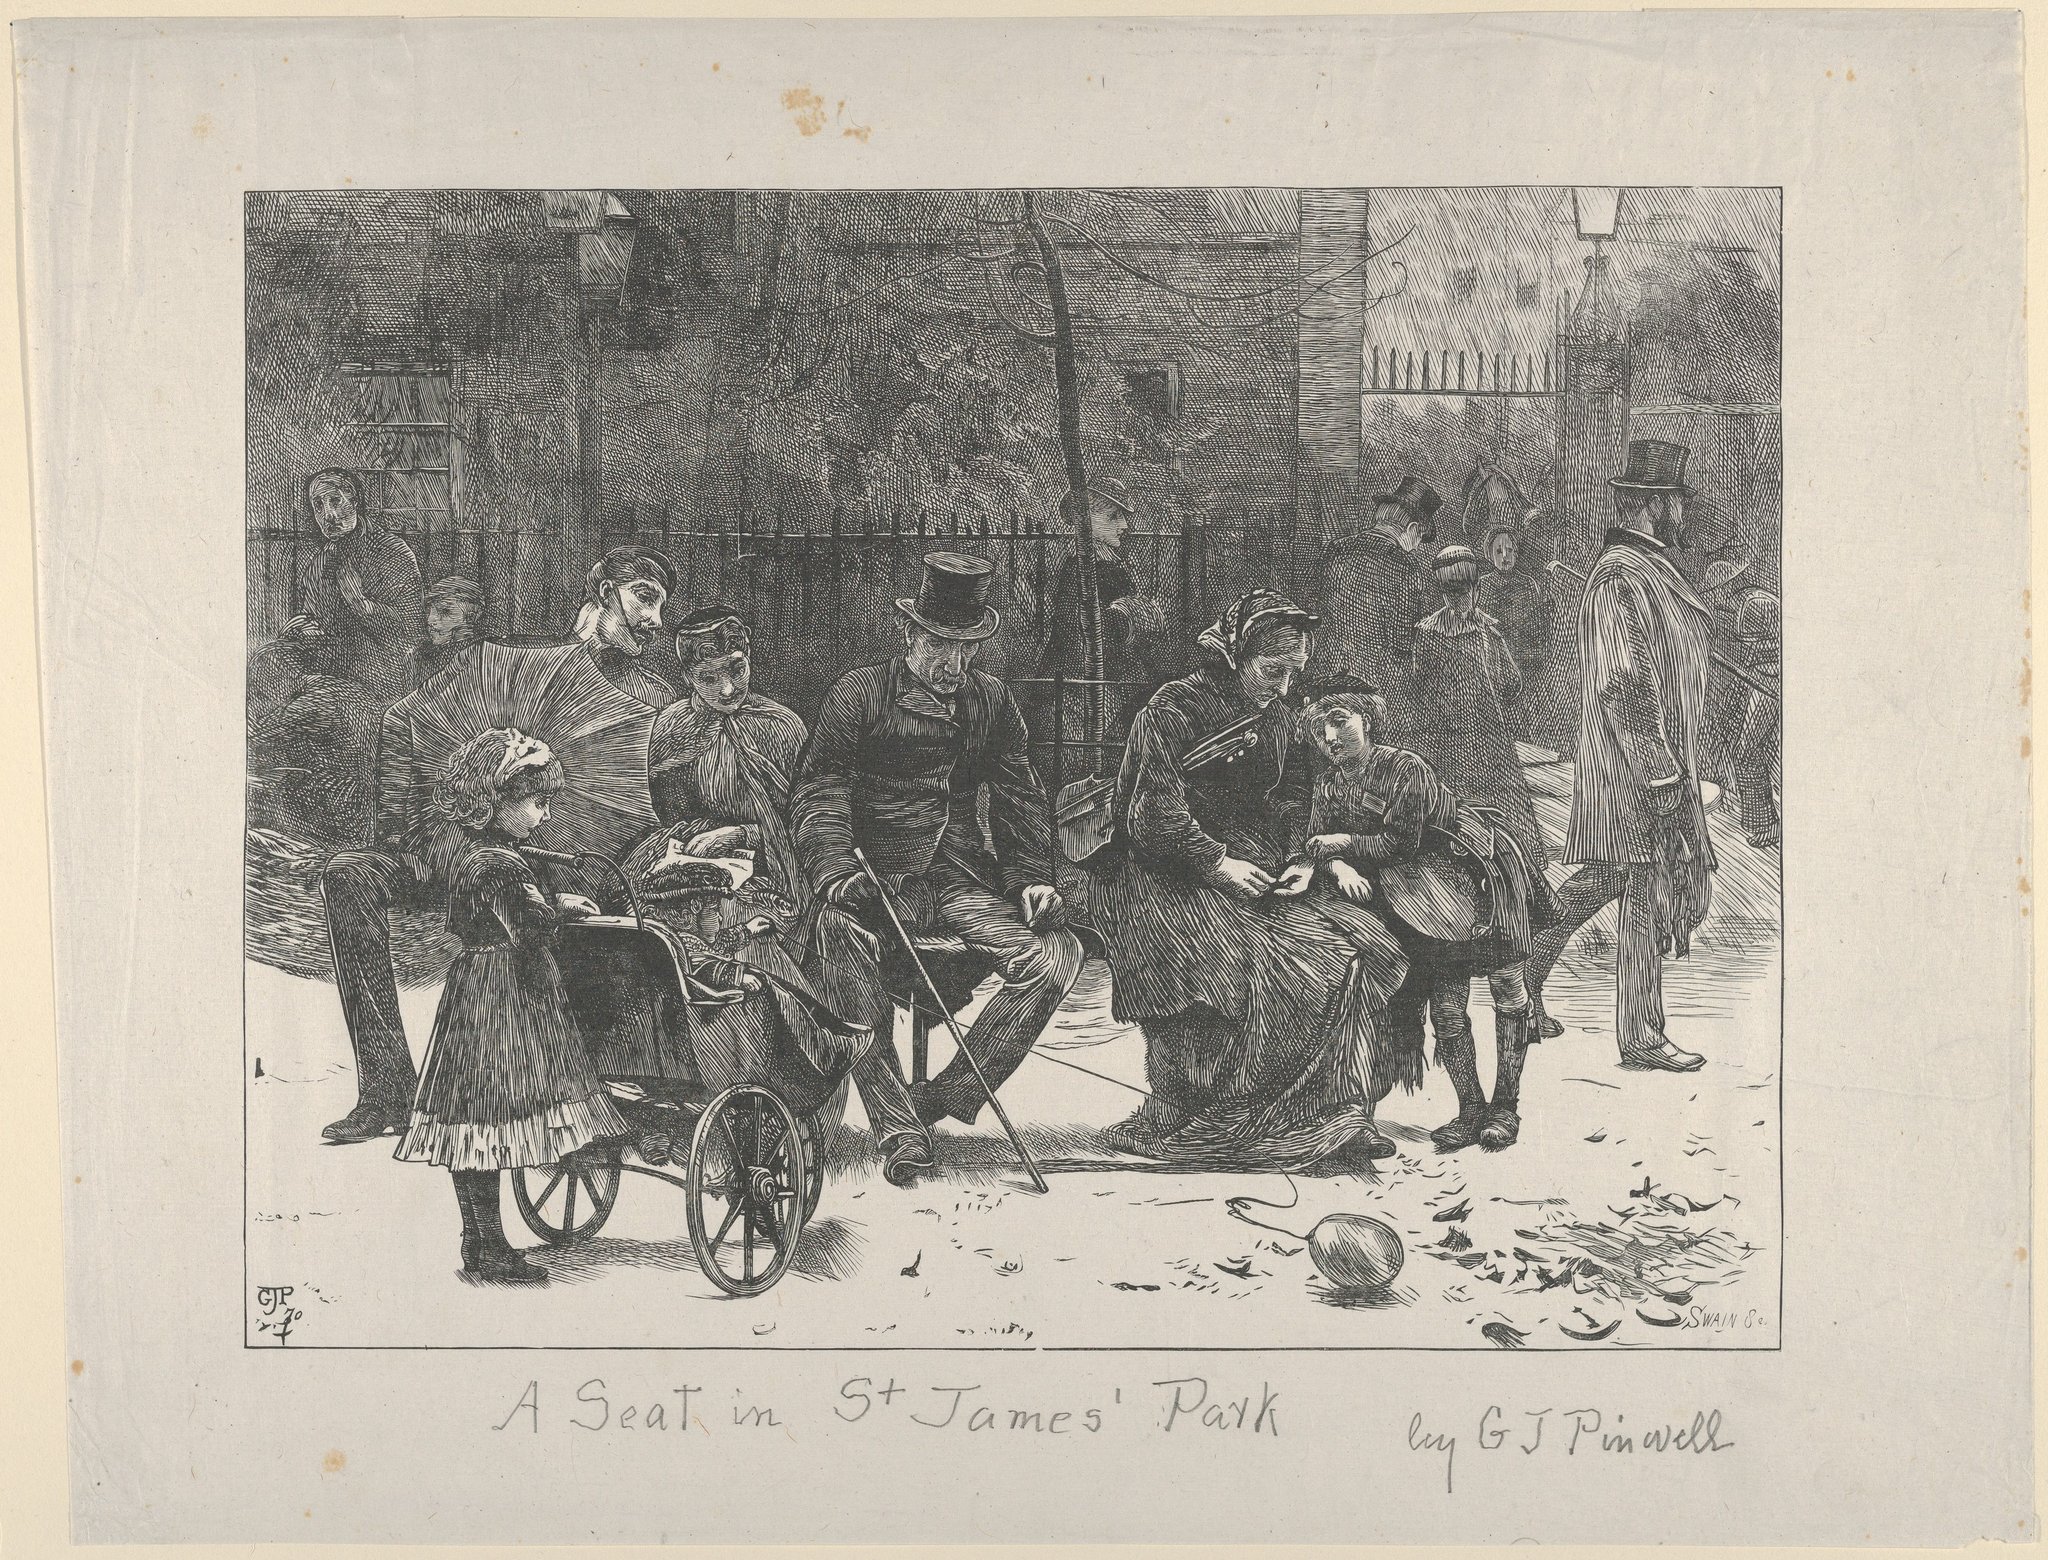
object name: print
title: A Seat in St. James's Park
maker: george john pinwell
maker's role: artist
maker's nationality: british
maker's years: 1842-1875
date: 1870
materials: chine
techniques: engraving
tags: parks,soldiers,girls,men,women